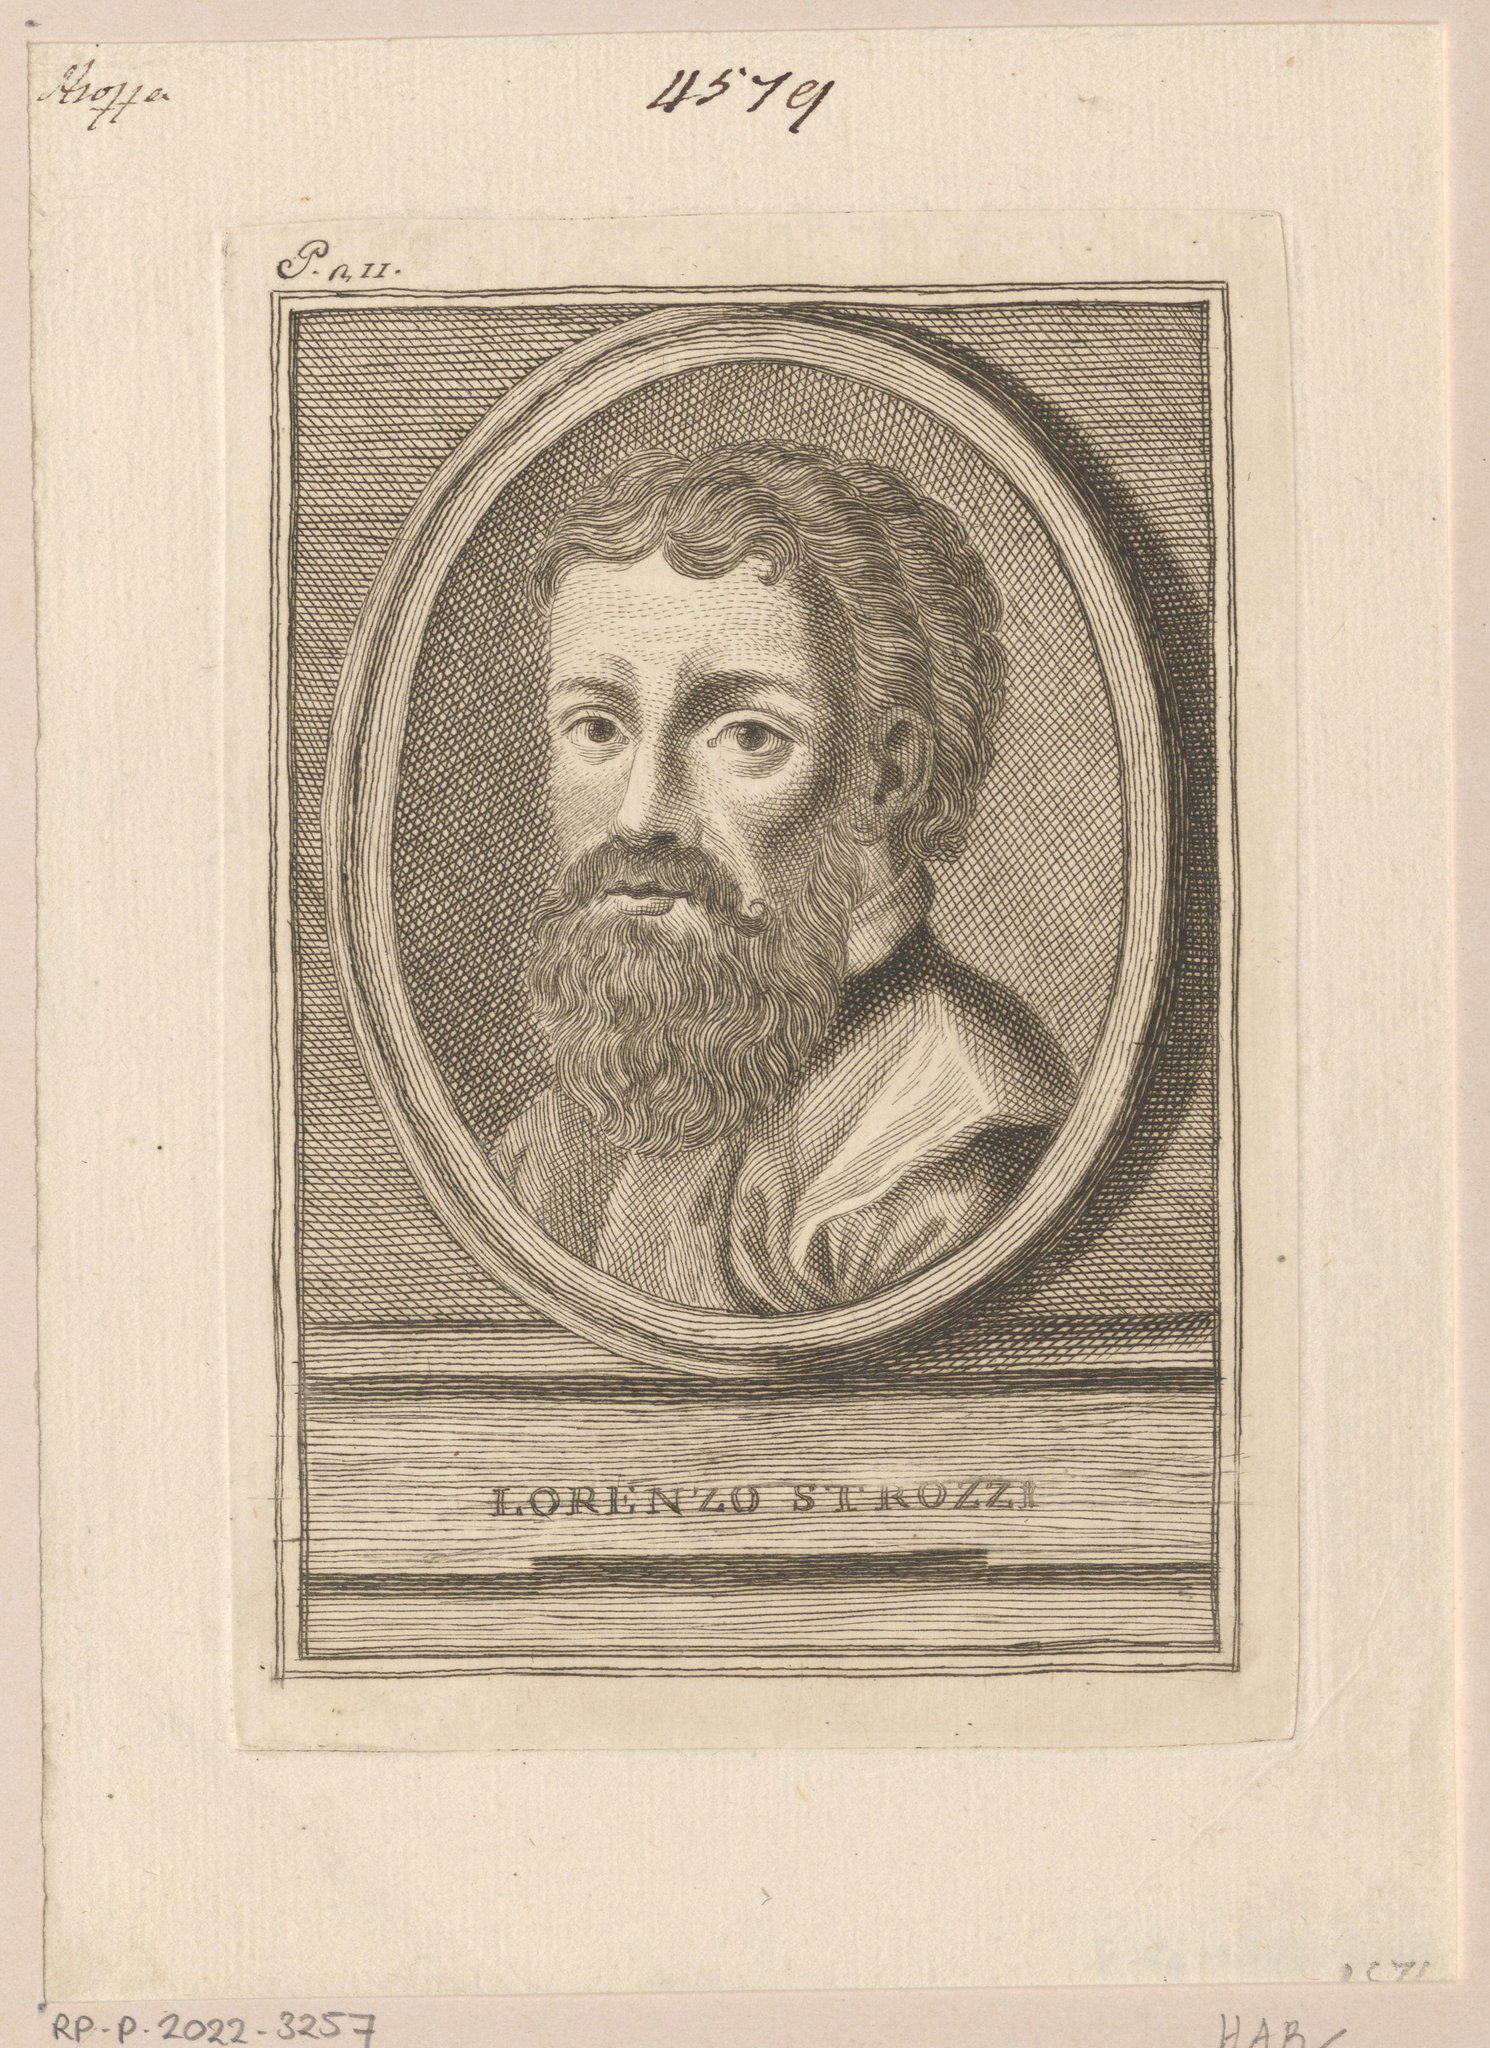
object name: print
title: Portret van Lorenzo Strozzi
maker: Anonymous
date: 1650-1750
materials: paper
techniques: engraving, etching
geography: italy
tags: priest, archbishop, bishop, etc. (roman catholic), cardinal, historical persons